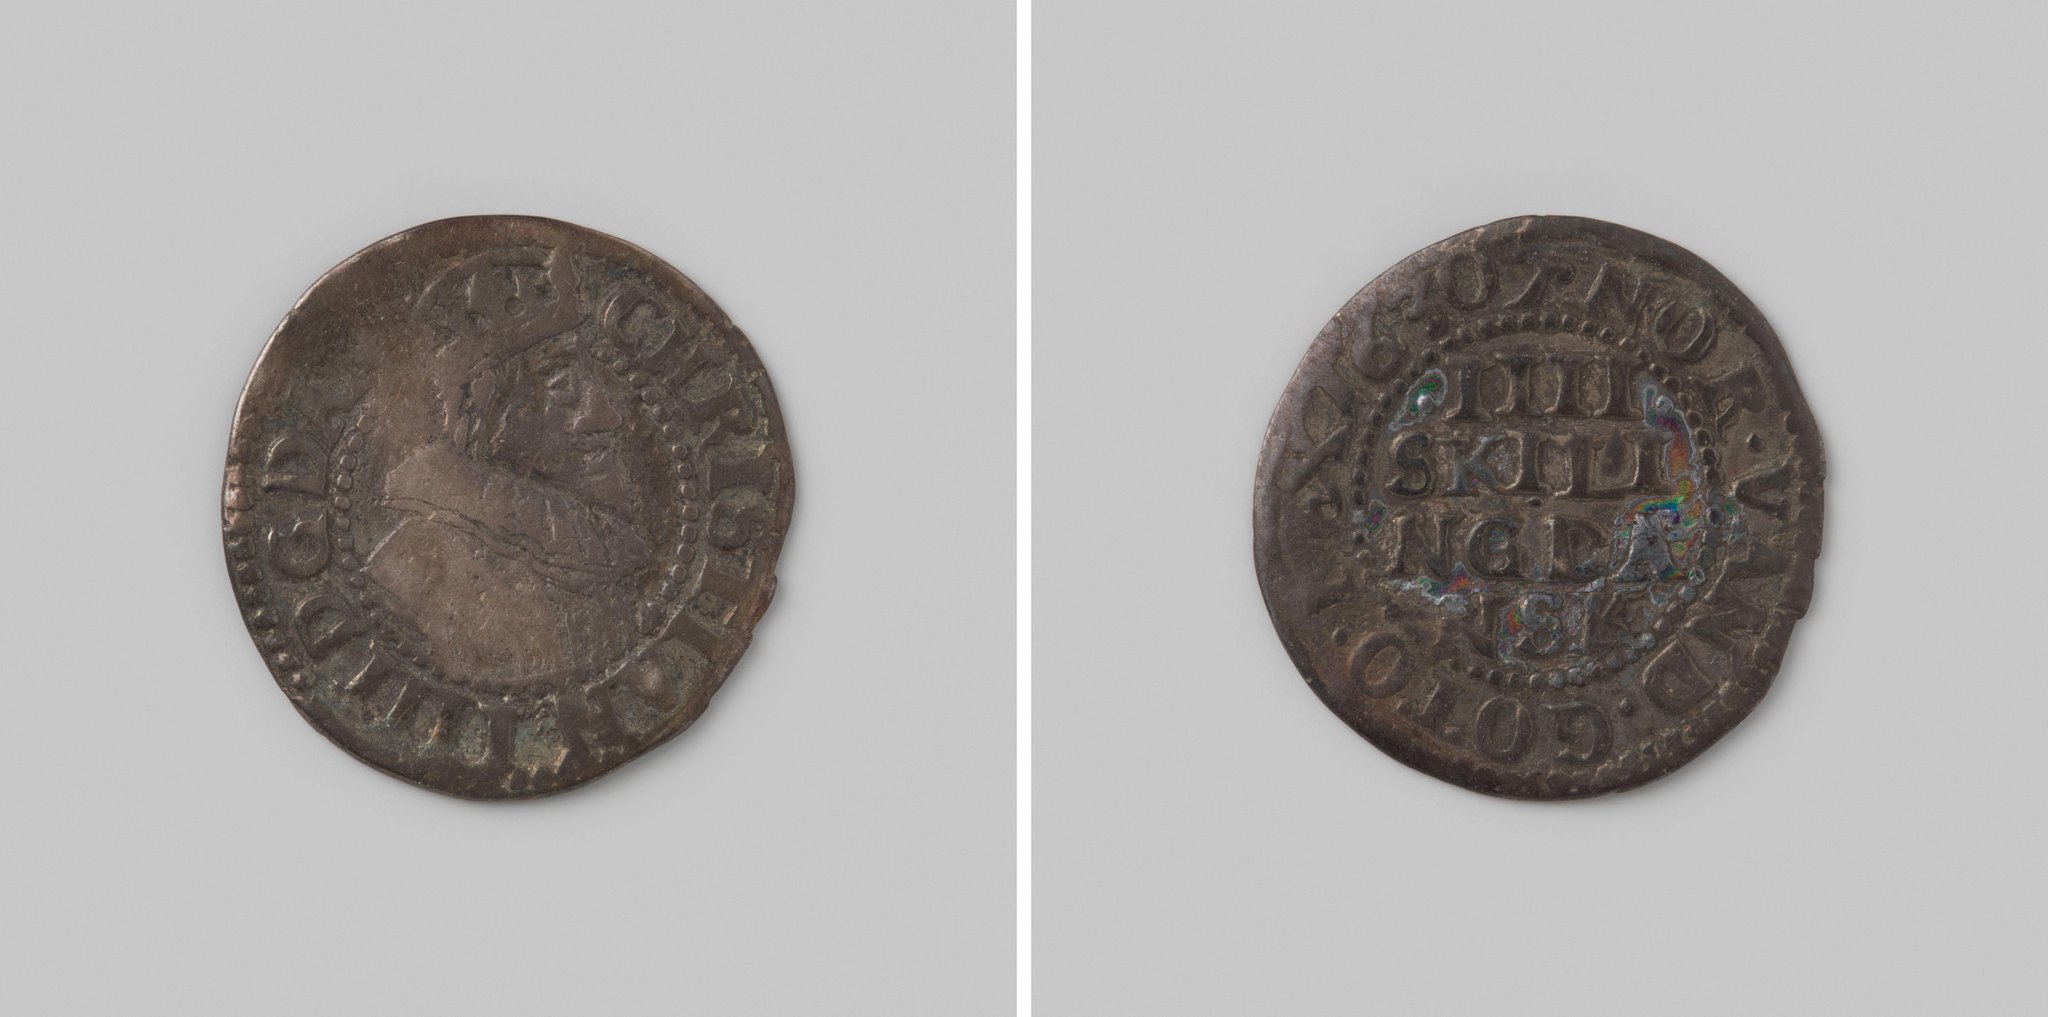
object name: coin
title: Denemarken, Christiaan IV, 4 skilling dansk, 1630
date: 1630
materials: silver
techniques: striking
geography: copenhagen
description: Zilveren munt. Voorzijde: gekroond borstbeeld van de koning naar rechts. Keerzijde: waarde-aanduiding in vier regels. Jaartal bovenaan aan het eind van het omschrift. Gladde rand.